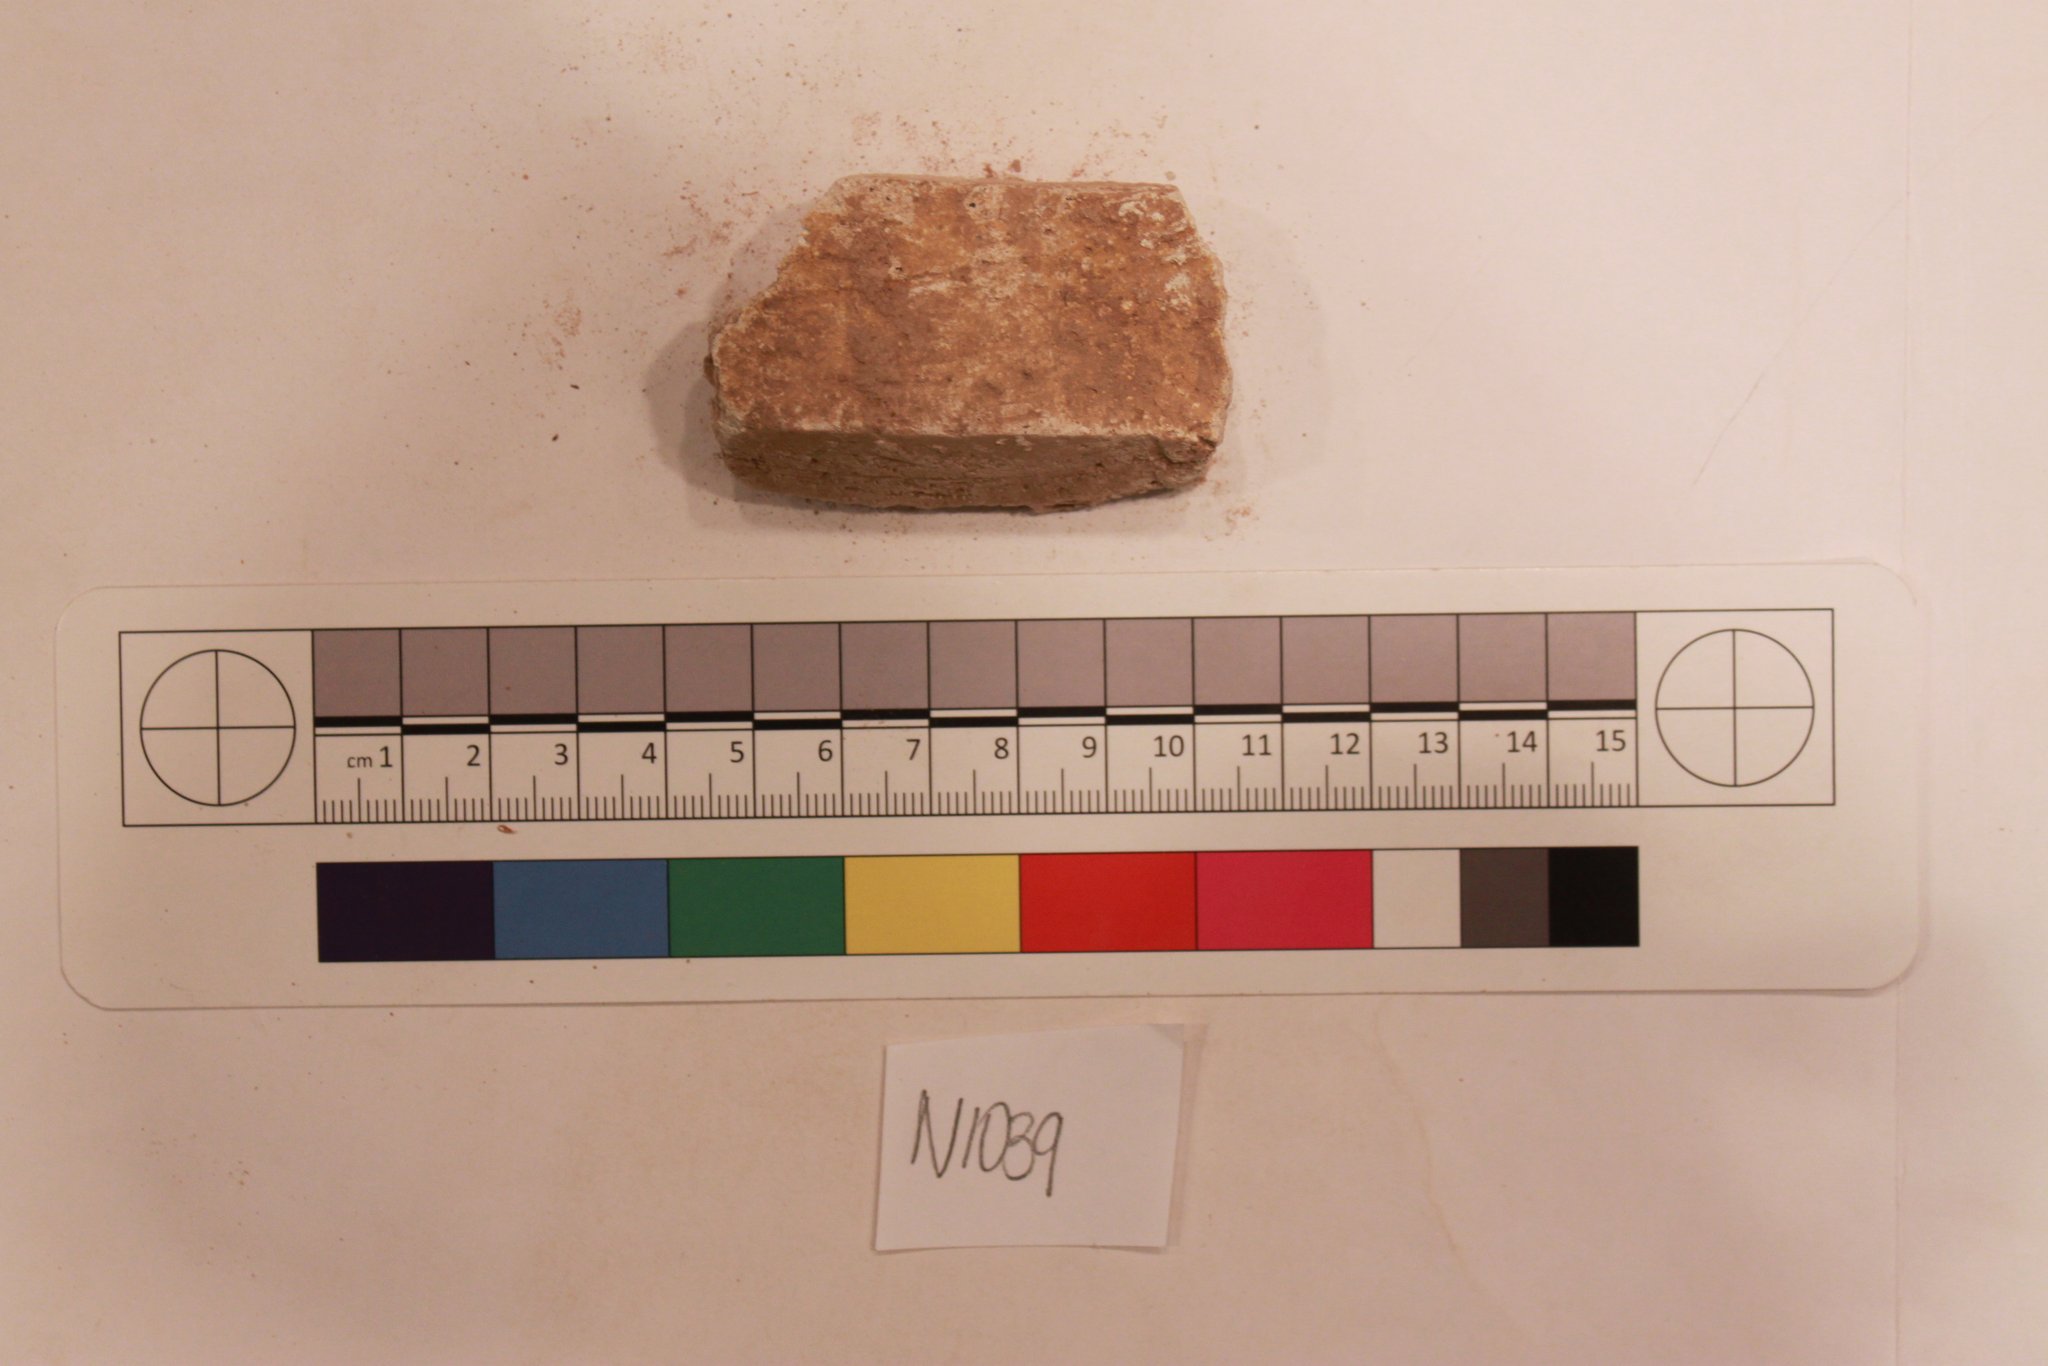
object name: fragment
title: Stucco Fragment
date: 701-1200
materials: plaster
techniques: carving, painting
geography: iran